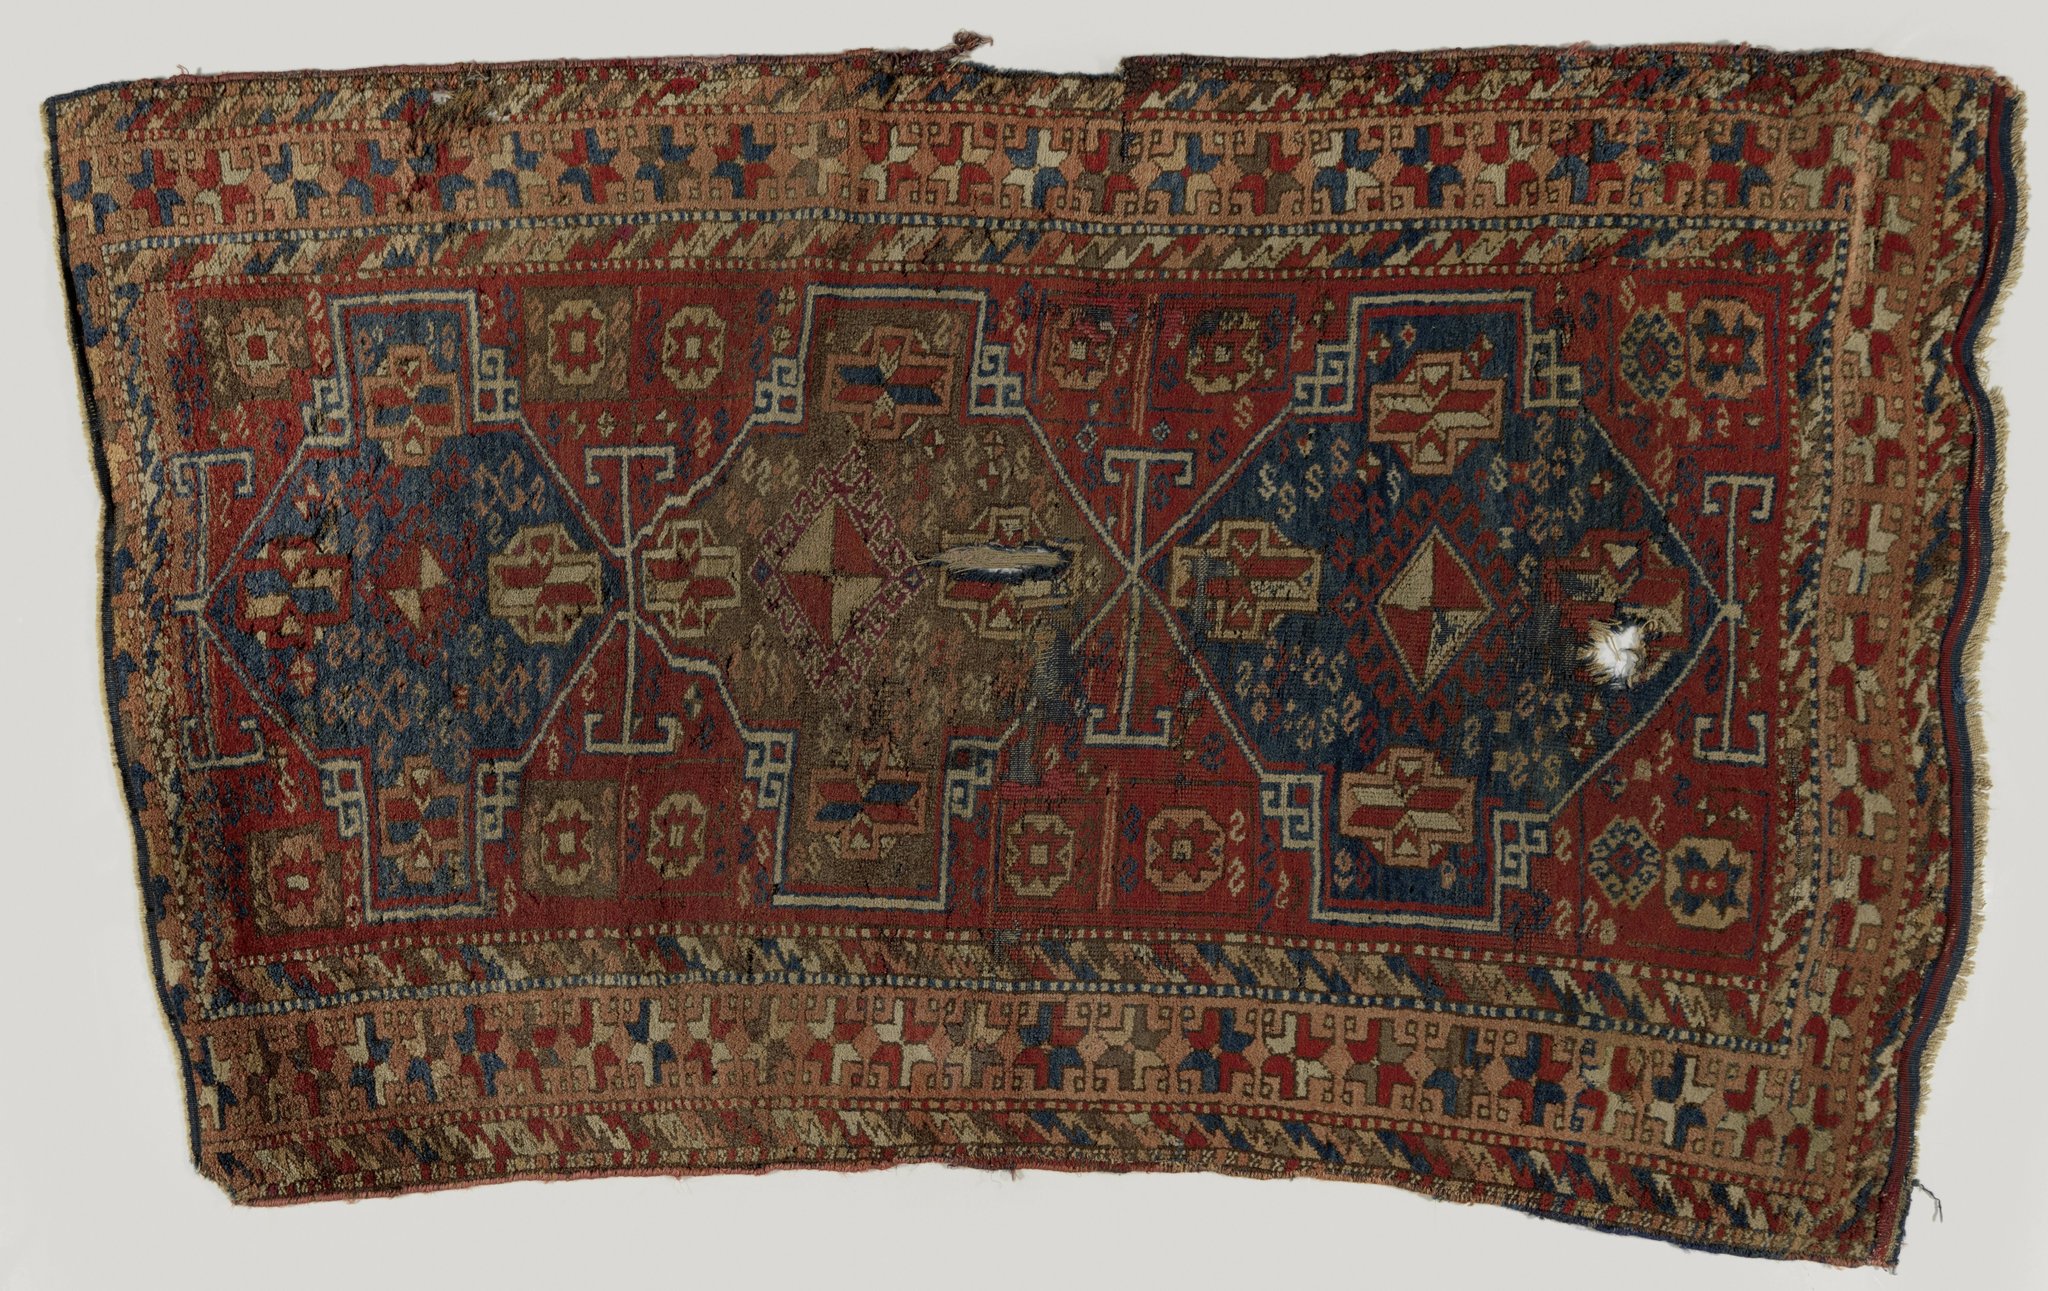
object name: oriental rug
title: Oosters tapijt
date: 1875-1900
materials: wool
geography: kemerihisar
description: Oosters tapijt, medaillonkleed. In het middenveld drie aaneengesloten medaillons en blokken met een ster. De breedste rand is versierd met sterren.